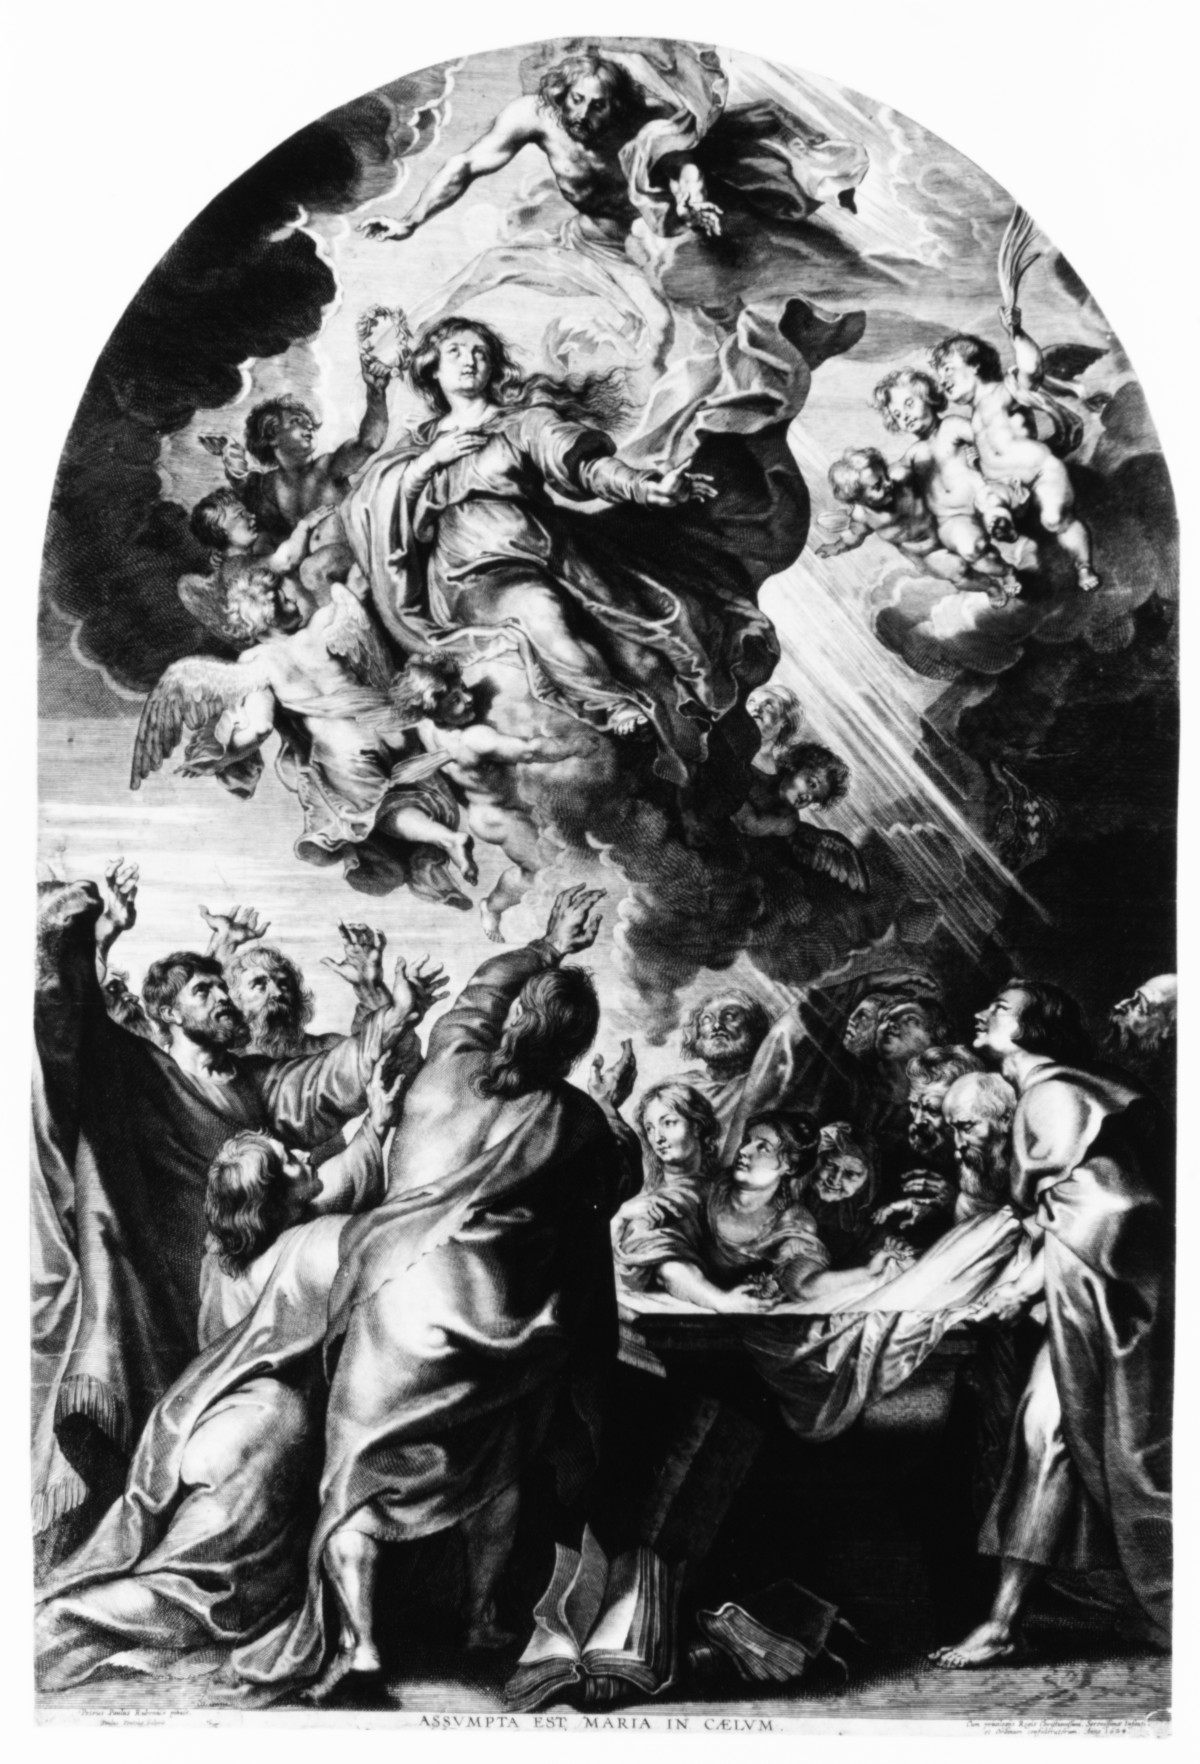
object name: print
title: Assumption of the Virgin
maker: paulus pontius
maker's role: engraver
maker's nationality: flemish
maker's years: 1603-1658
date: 1624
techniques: engraving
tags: men,women,angels,assumption of the virgin